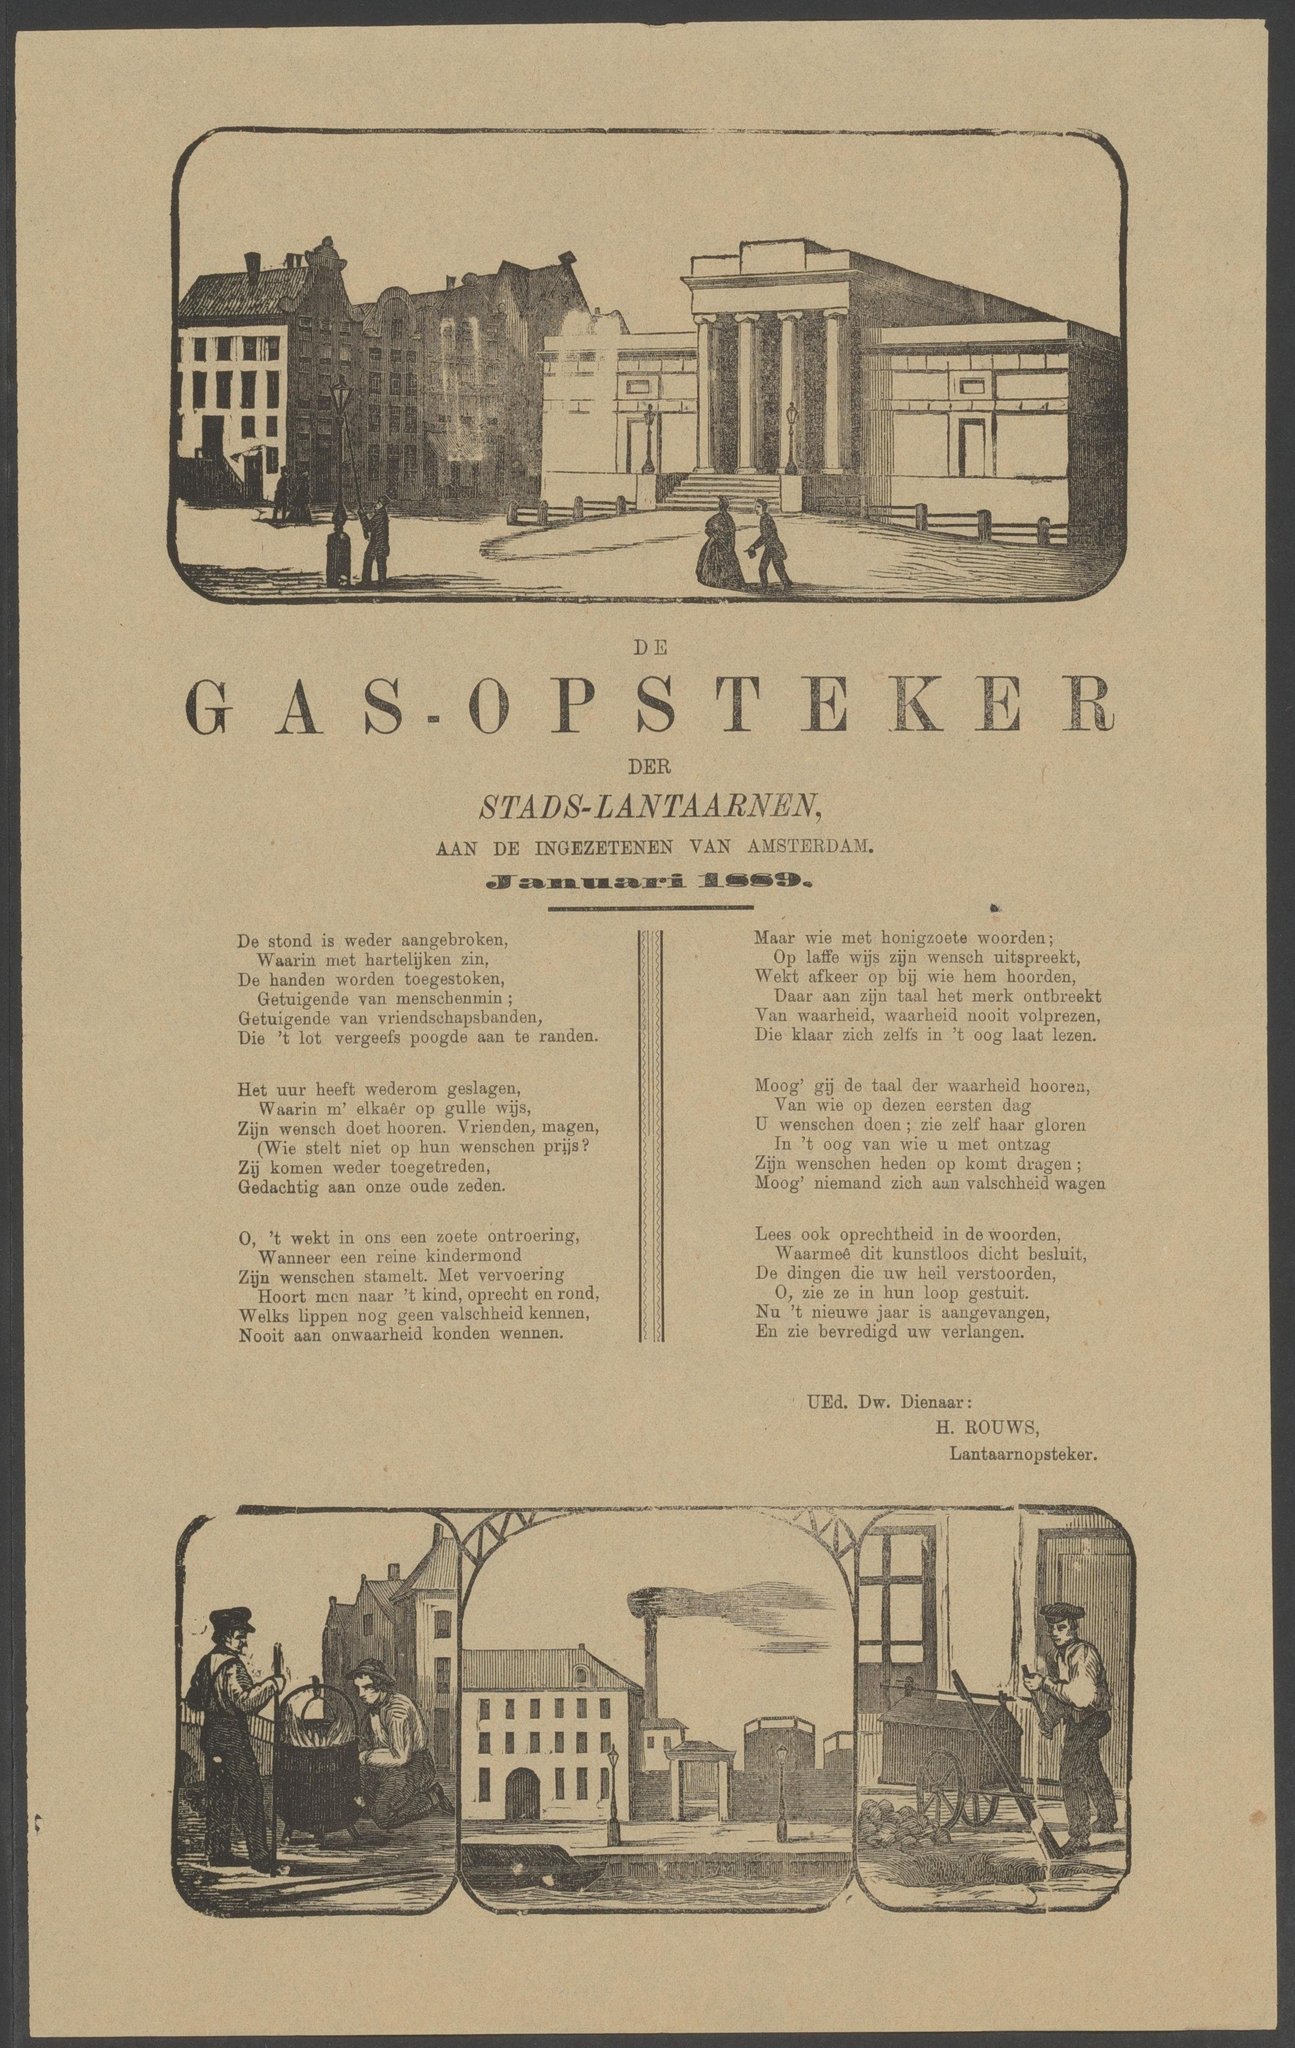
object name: print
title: De Gas-Opsteker der Stads-Lantaarnen, aan de ingezetenen van Amsterdam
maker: Anonymous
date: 1888-1889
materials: paper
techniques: letterpress printing, engraving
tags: gas-lamp, gas supply, digging (industrial process), street lighting, amsterdam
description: Nieuwjaarswens van de Amsterdamse gaslantaarnopstekers voor het jaar 1889. Centraal een vers in twee kolommen. Bovenaan de Dam met de beurs van Zocher te Amsterdam. Onderaan de Hollandsche Gasfabriek en twee gasfitters aan het werk. Van de gaslantaarnopsteker: H. Rouws. Onderwerpsrubrieken binnen de Atlas Zeden en Gewoonten: Zeden en gewoonten in engeren zin, Volksleven, Volksbladen, Nieuwjaars- en Kerstwenschen, Amsterdam.